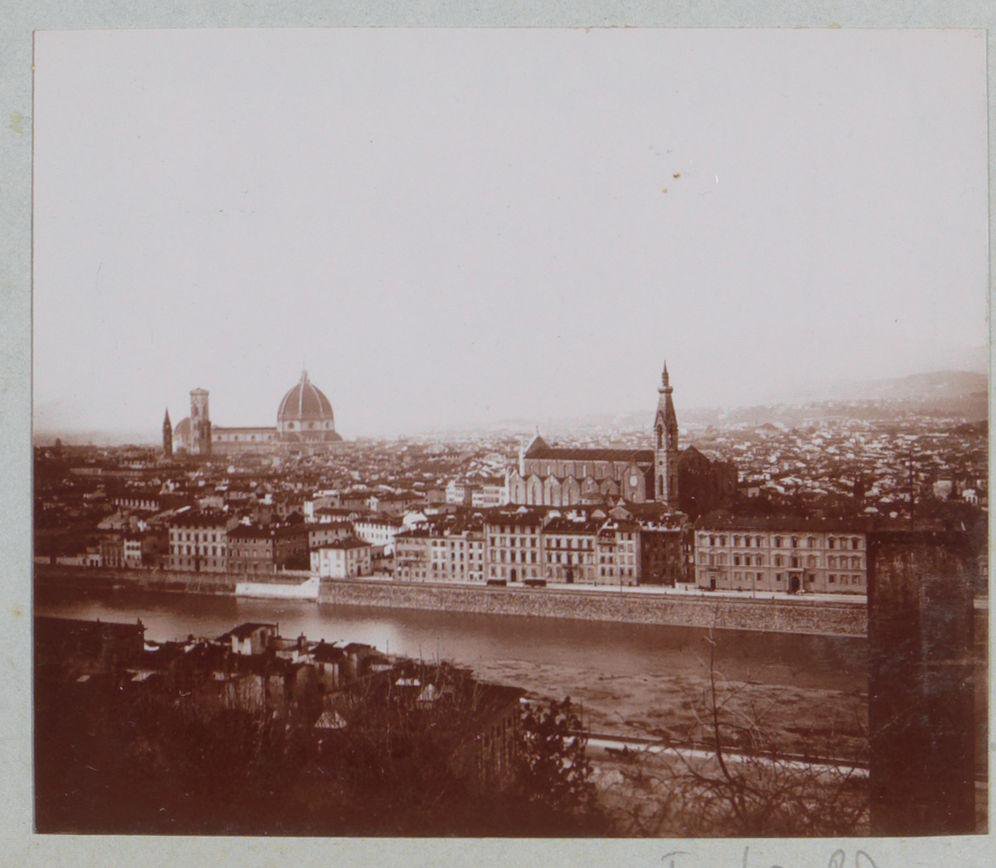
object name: photograph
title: Gezicht op Florence met links aan de horizon de Kathedraal van Florence en op de voorgrond Basilica di Santa Croce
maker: Anonymous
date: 1905-1910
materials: paper, photographic support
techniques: gelatin silver print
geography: florence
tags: church (exterior), prospect of city, town panorama, silhouette of city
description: Onderdeel van Fotoalbum van een Franse amateurfotograaf met bezienswaardigheden in Frankrijk, Zwitserland en Italië.